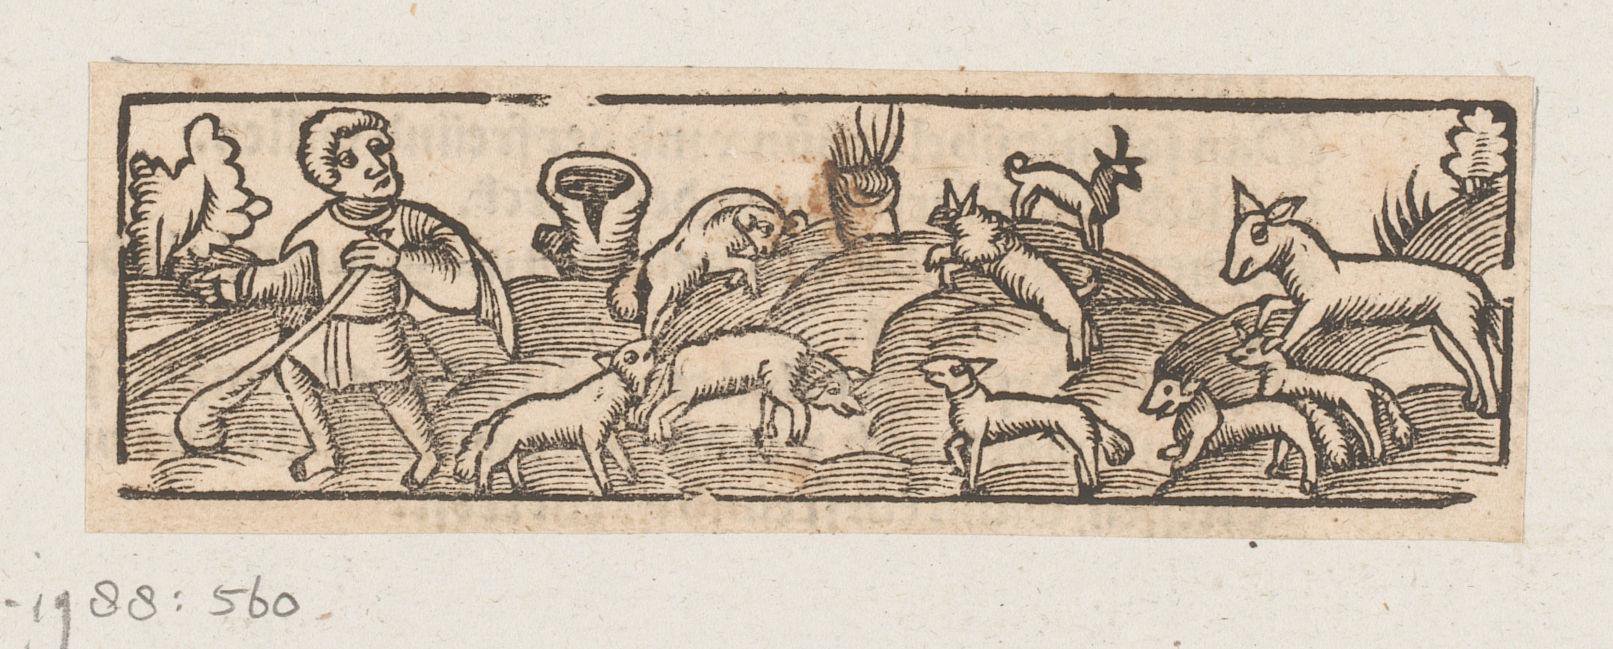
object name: book illustration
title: Herder met een kudde schapen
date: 1539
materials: paper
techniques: woodcut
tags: herding, herdsman, herdswoman, shepherd, shepherdess, cowherd, etc.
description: Illustratie uit: Bidpai. Das büch der Weissheyt der Alten weisen. Straatsburg: Jacob Fröhlich, 1539.